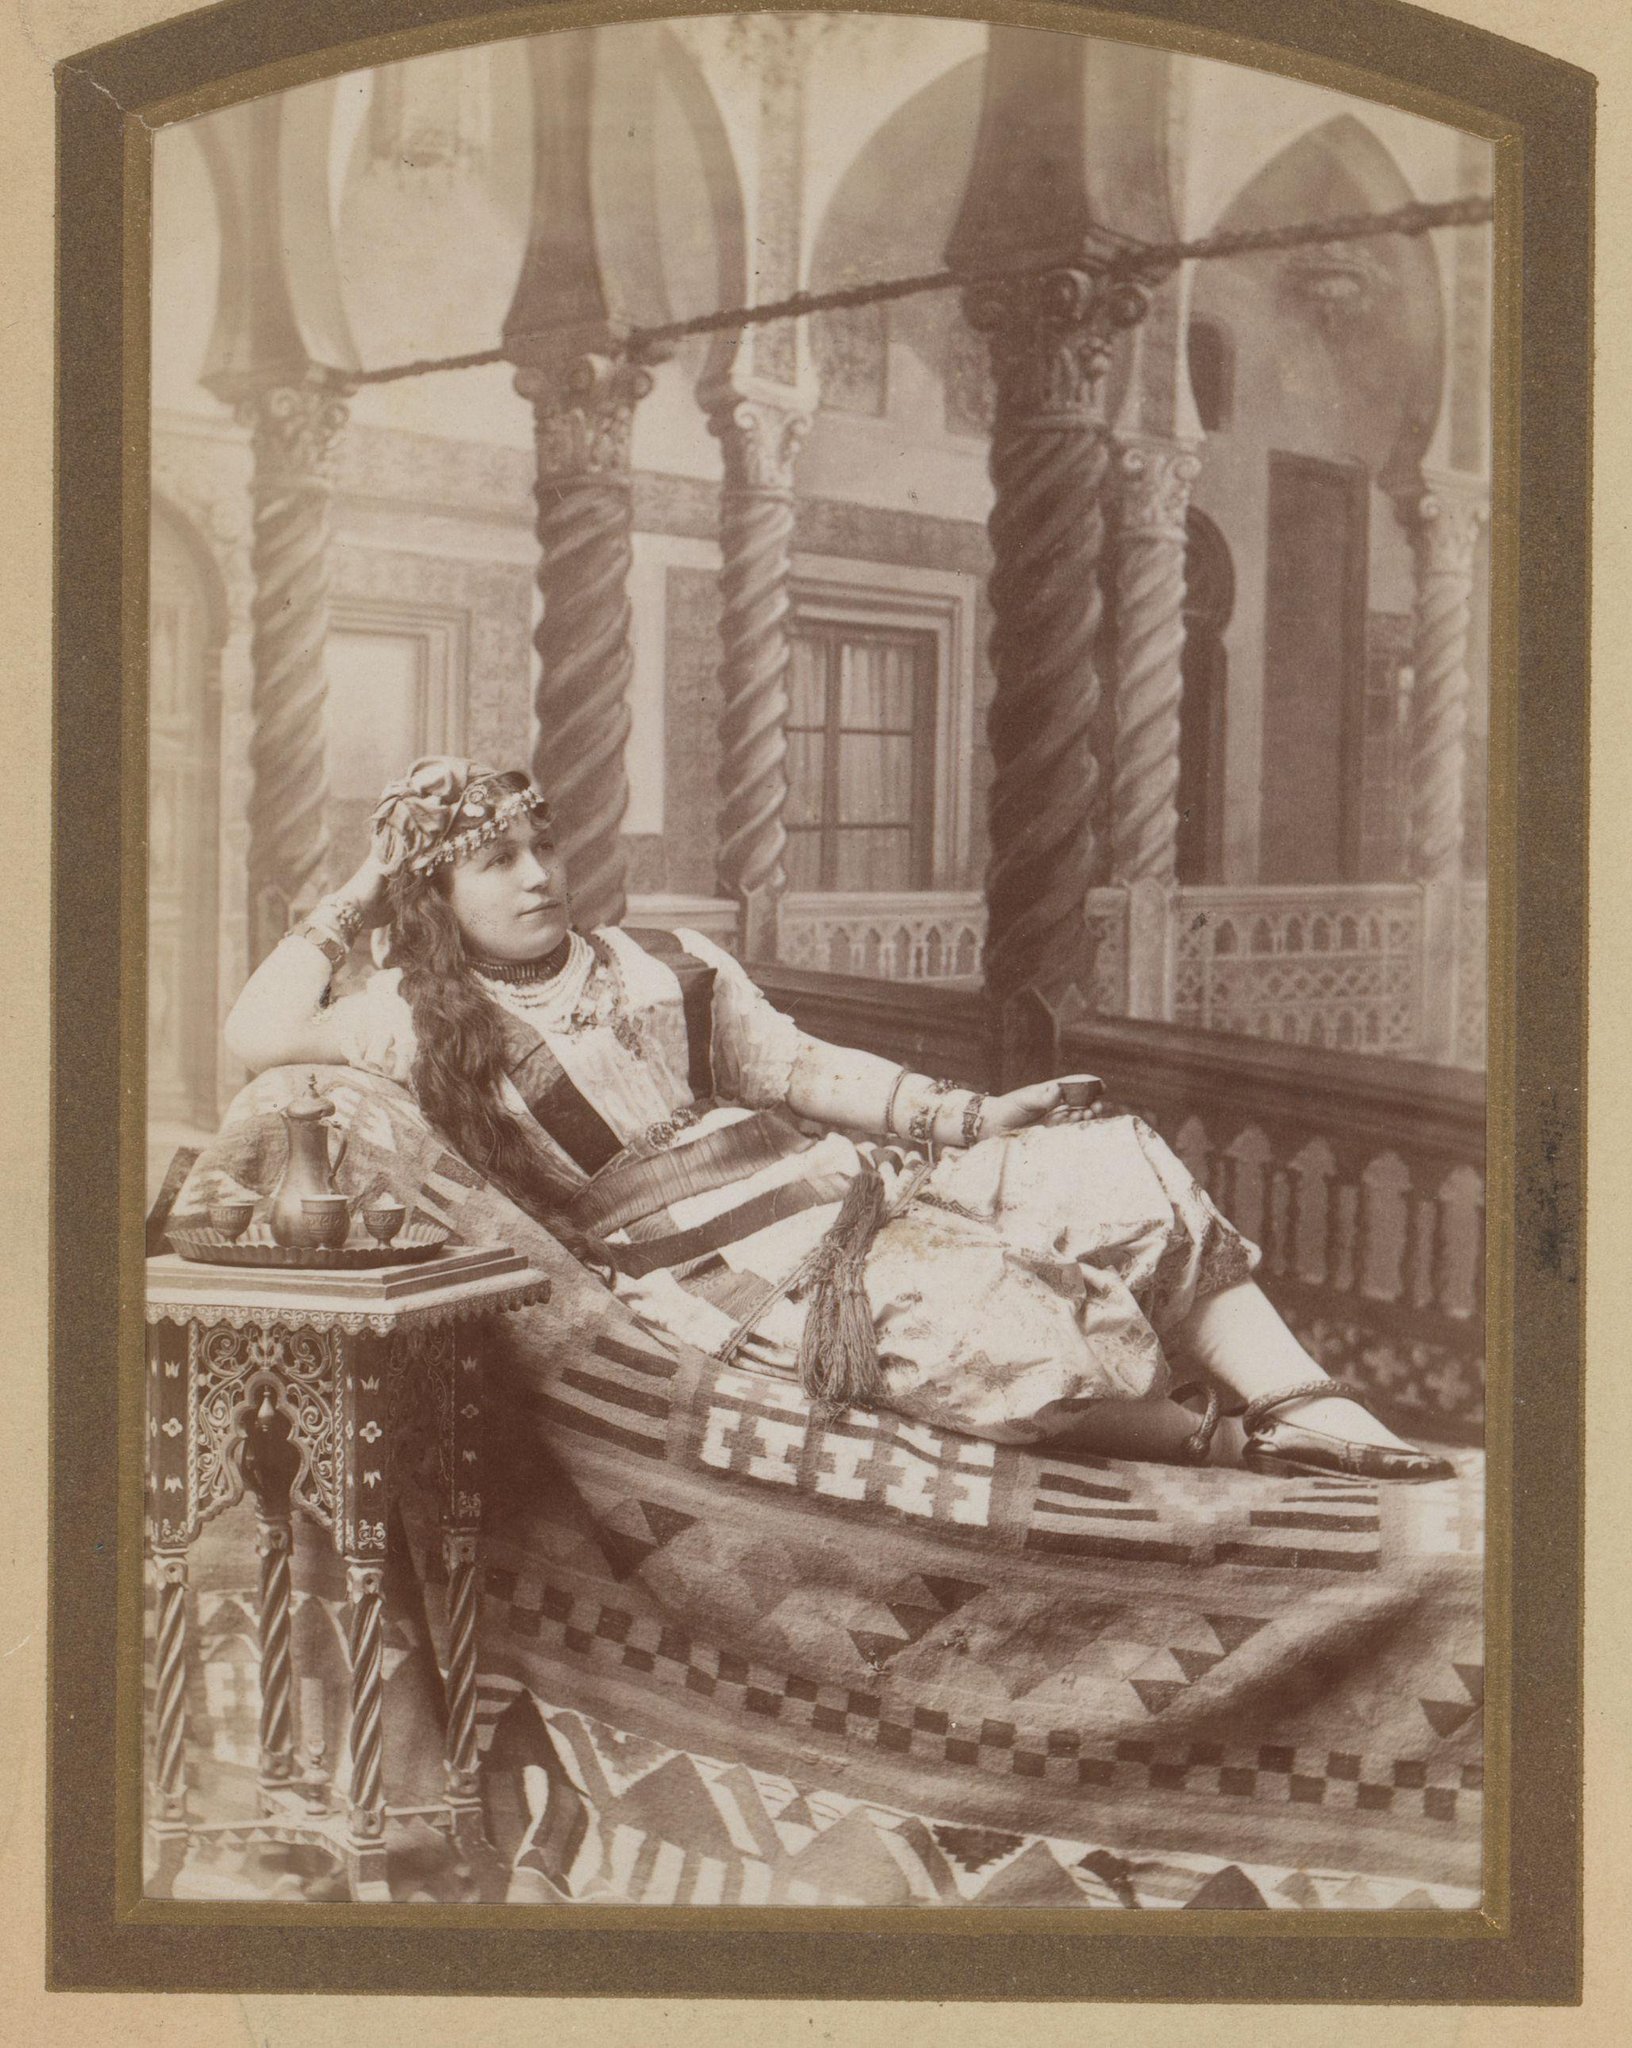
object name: photograph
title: Portret van een vrouw op een canapé, vermoedelijk een odalisk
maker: jean geiser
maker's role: fotograaf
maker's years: 1848-1923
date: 1880-1910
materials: cardboard, photographic support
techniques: albumen print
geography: algiers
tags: historical persons - bb - woman, moustache, odalisque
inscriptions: inscription: ‘1872 - 1873 - 1878/ LYON - VIENNE - PARIS/ Photographie/ Jean Geiser/ PEINTRE PHOTOGRAPHE/ 7, Rue Bab-Azoun, 7./ Entrée Escalier de Chartres au 1er./ ALGER/ SUCCURSALE À BLIDAH/ Vues, Types de toute/ l'Algérie/ Tous les Clichés sont conservés’